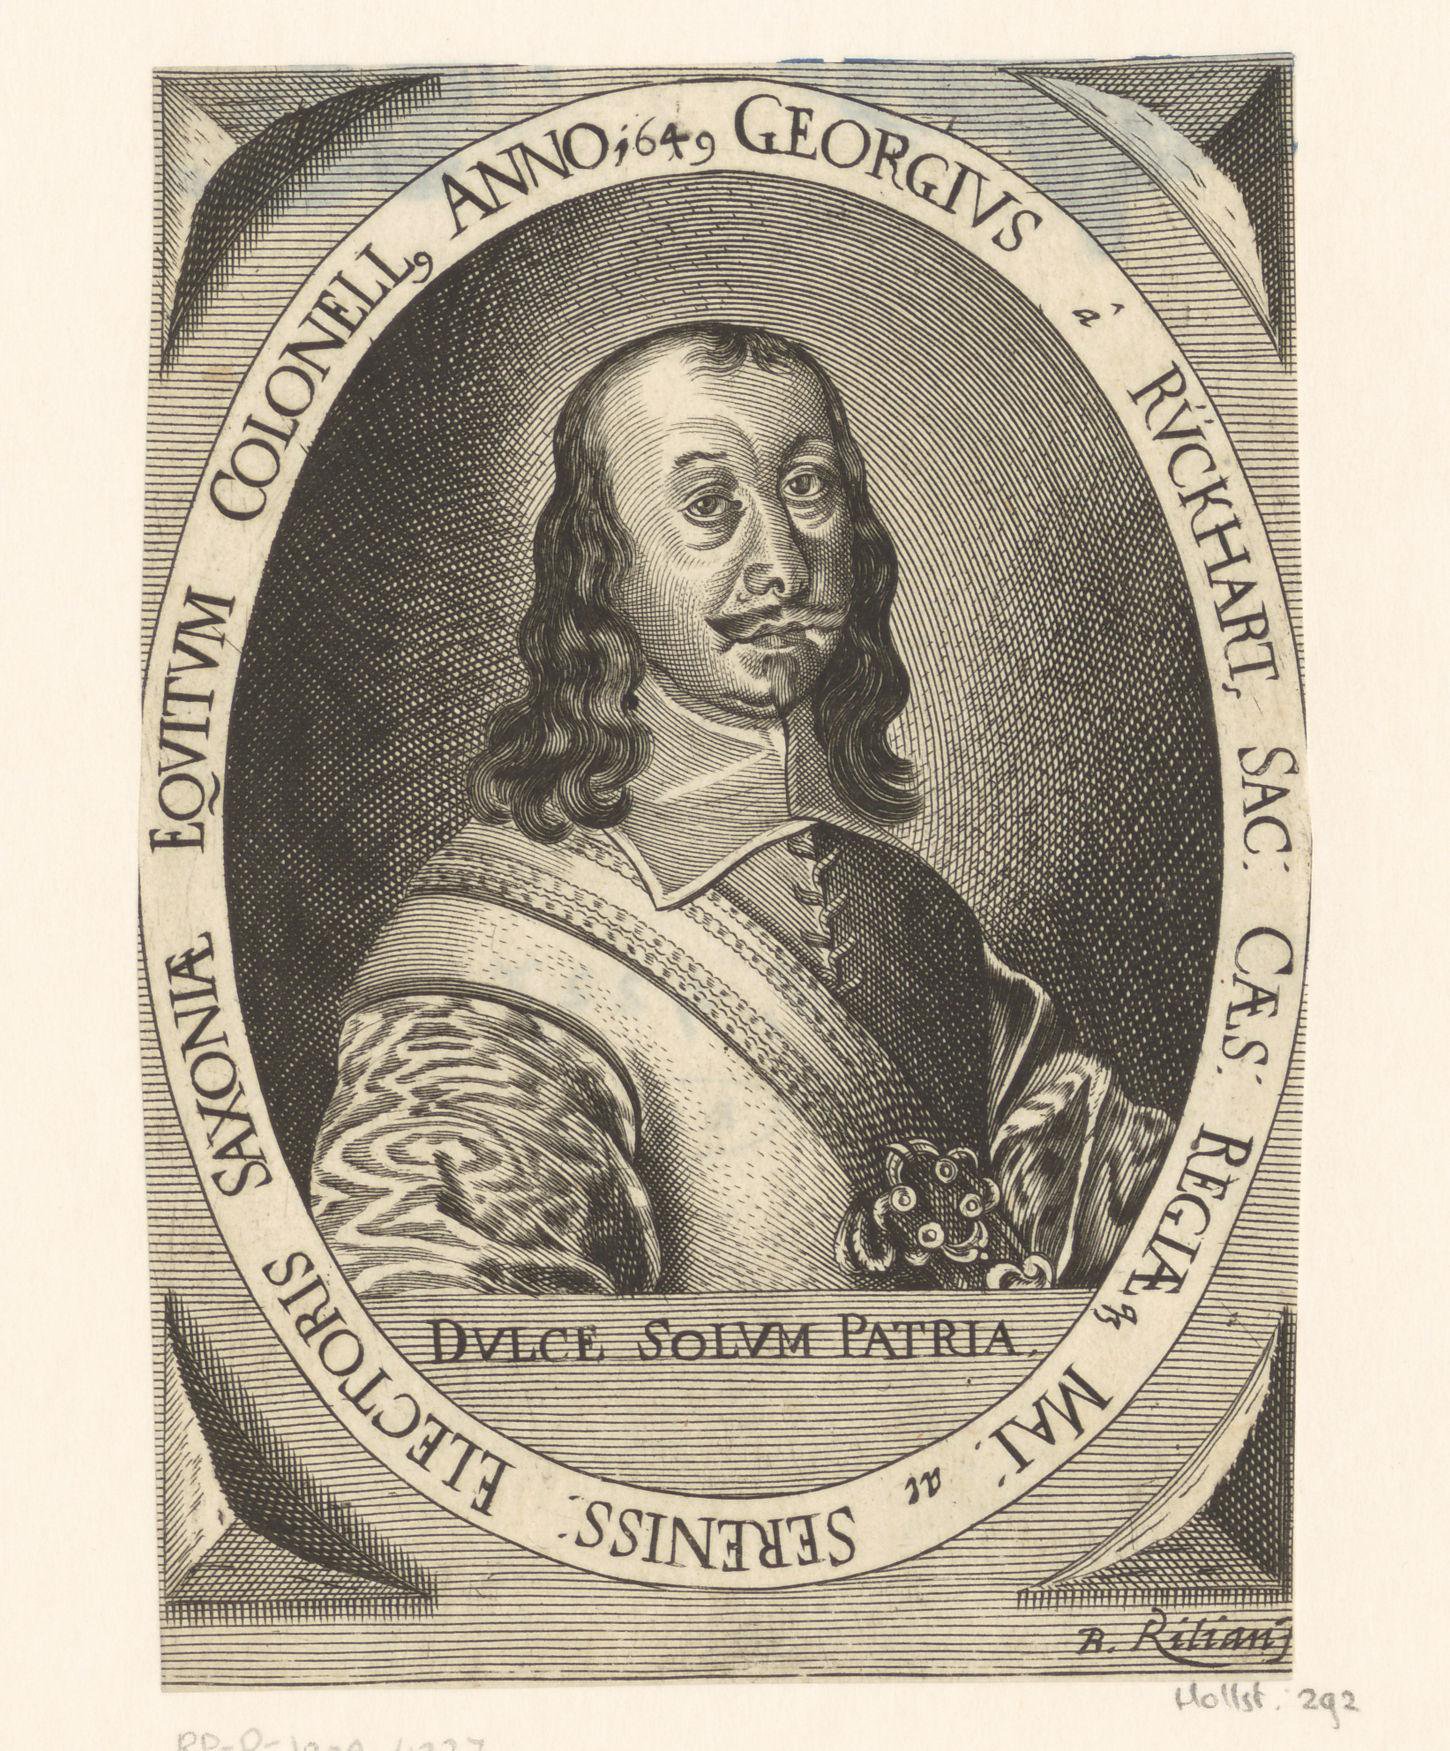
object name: print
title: Portret van Georg Rückhart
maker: bartholomäus kilian (ii)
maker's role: artist, draughtsman, print maker, publisher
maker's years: 1630-1696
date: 1649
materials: paper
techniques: engraving, etching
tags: historical persons, officer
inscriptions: collector's mark: Lugt 2228